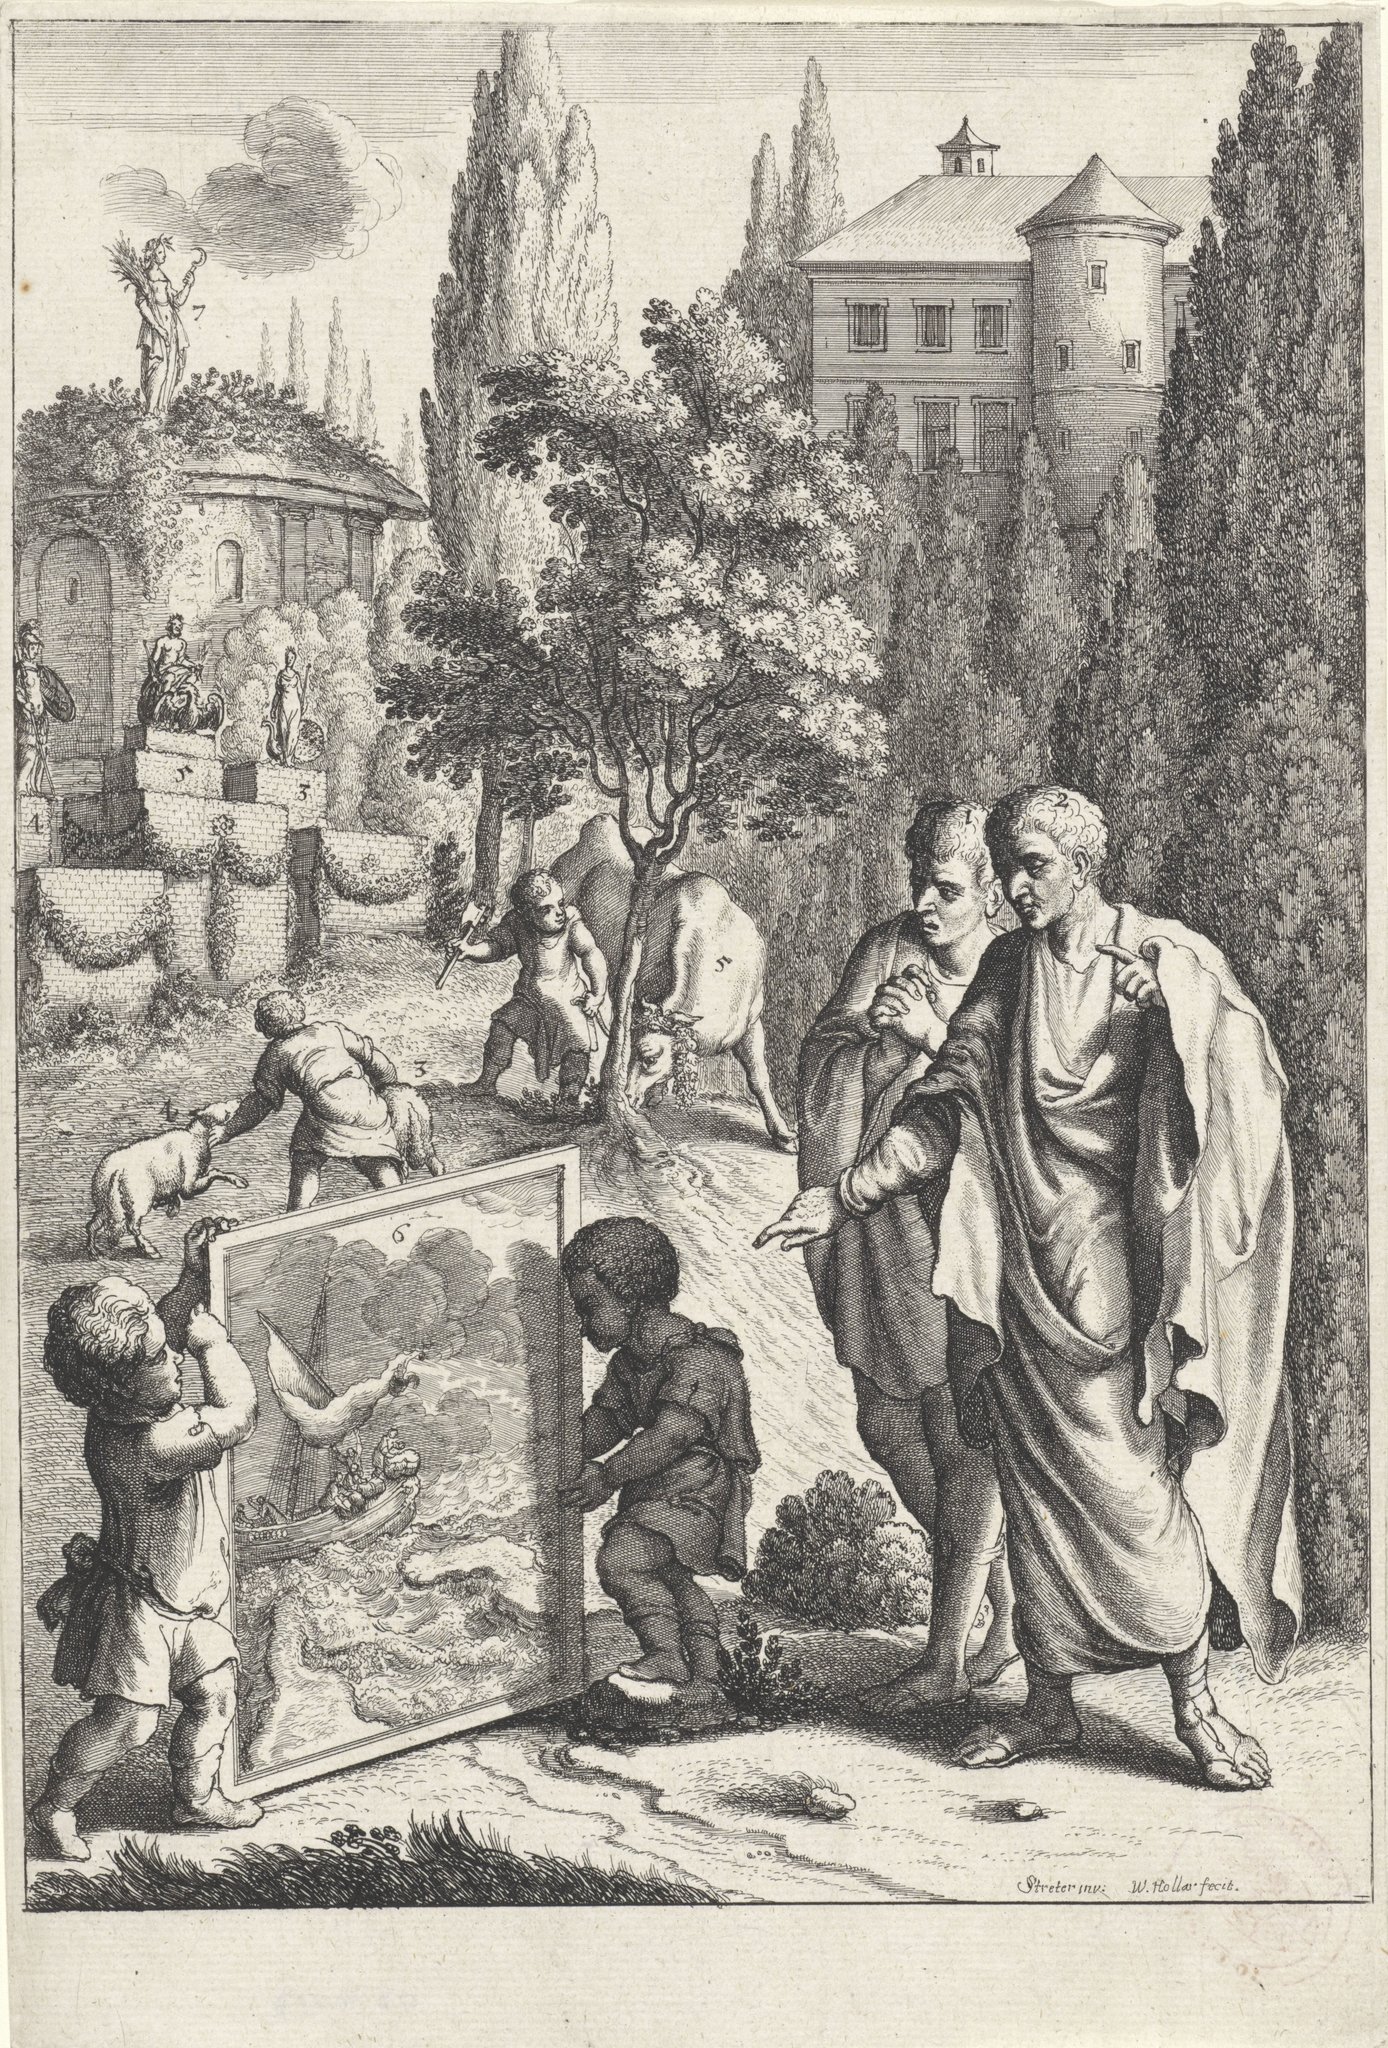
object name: print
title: Catallus gered na een schipbreuk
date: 1660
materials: paper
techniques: etching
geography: london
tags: garden, shipwreck, picture, painting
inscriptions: collector's mark: Lugt 240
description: Illustratie opgenomen in: Juvenalis. Mores hominum. The Manners of Men, Described in sixteen Satyrs. Londen: R. Hodgkinsonne, 1660.